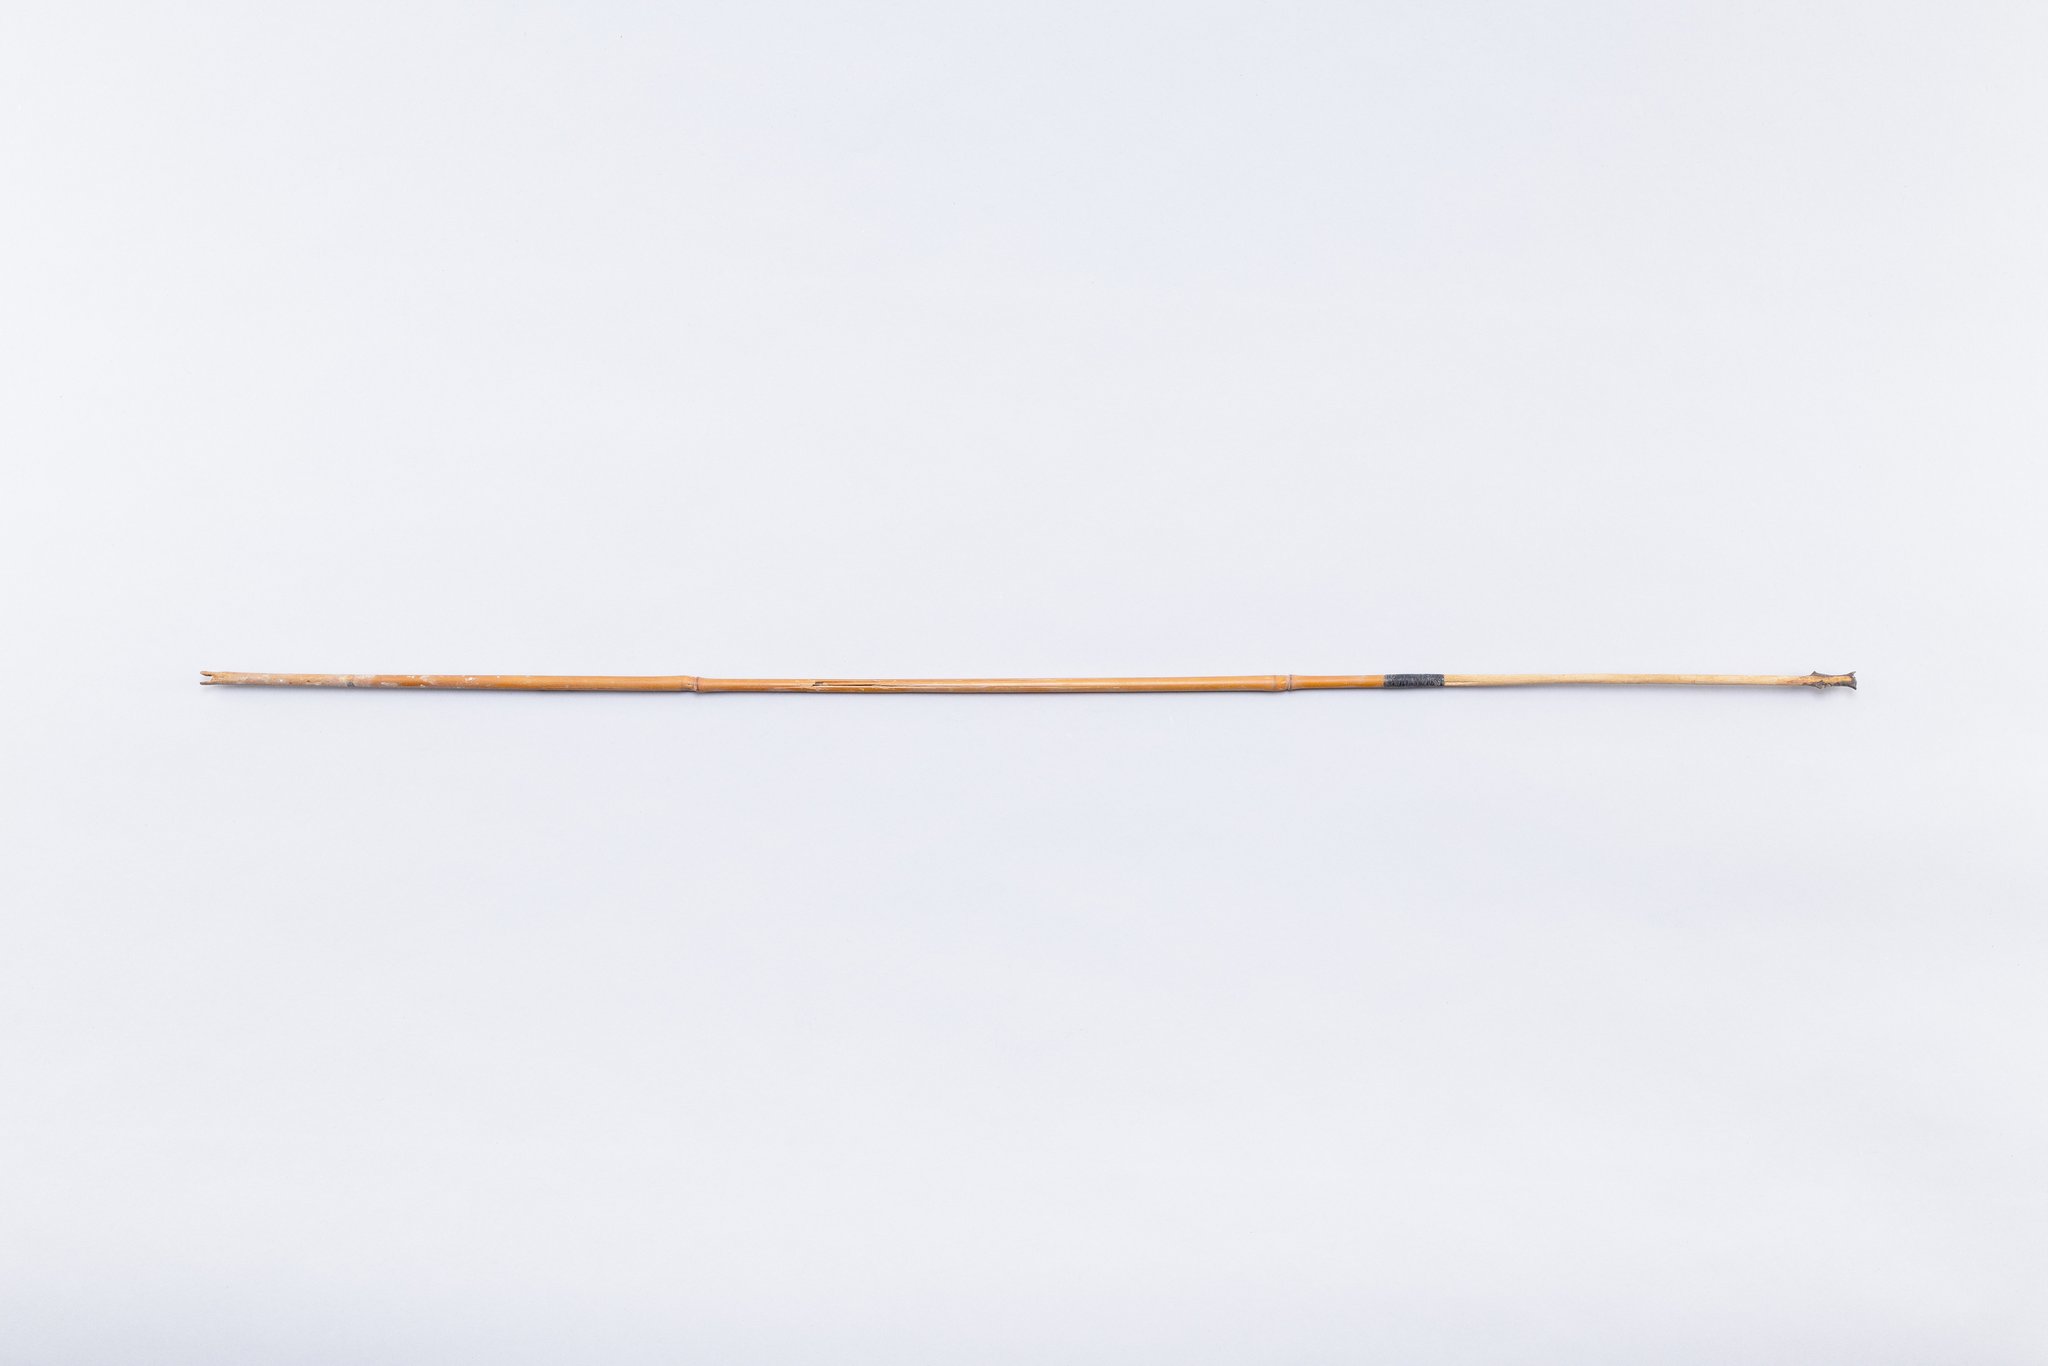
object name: arrow, arrowhead, adhesive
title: Arrow with composite stone tip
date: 1479-1458 BCE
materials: quartz, wood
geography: egypt